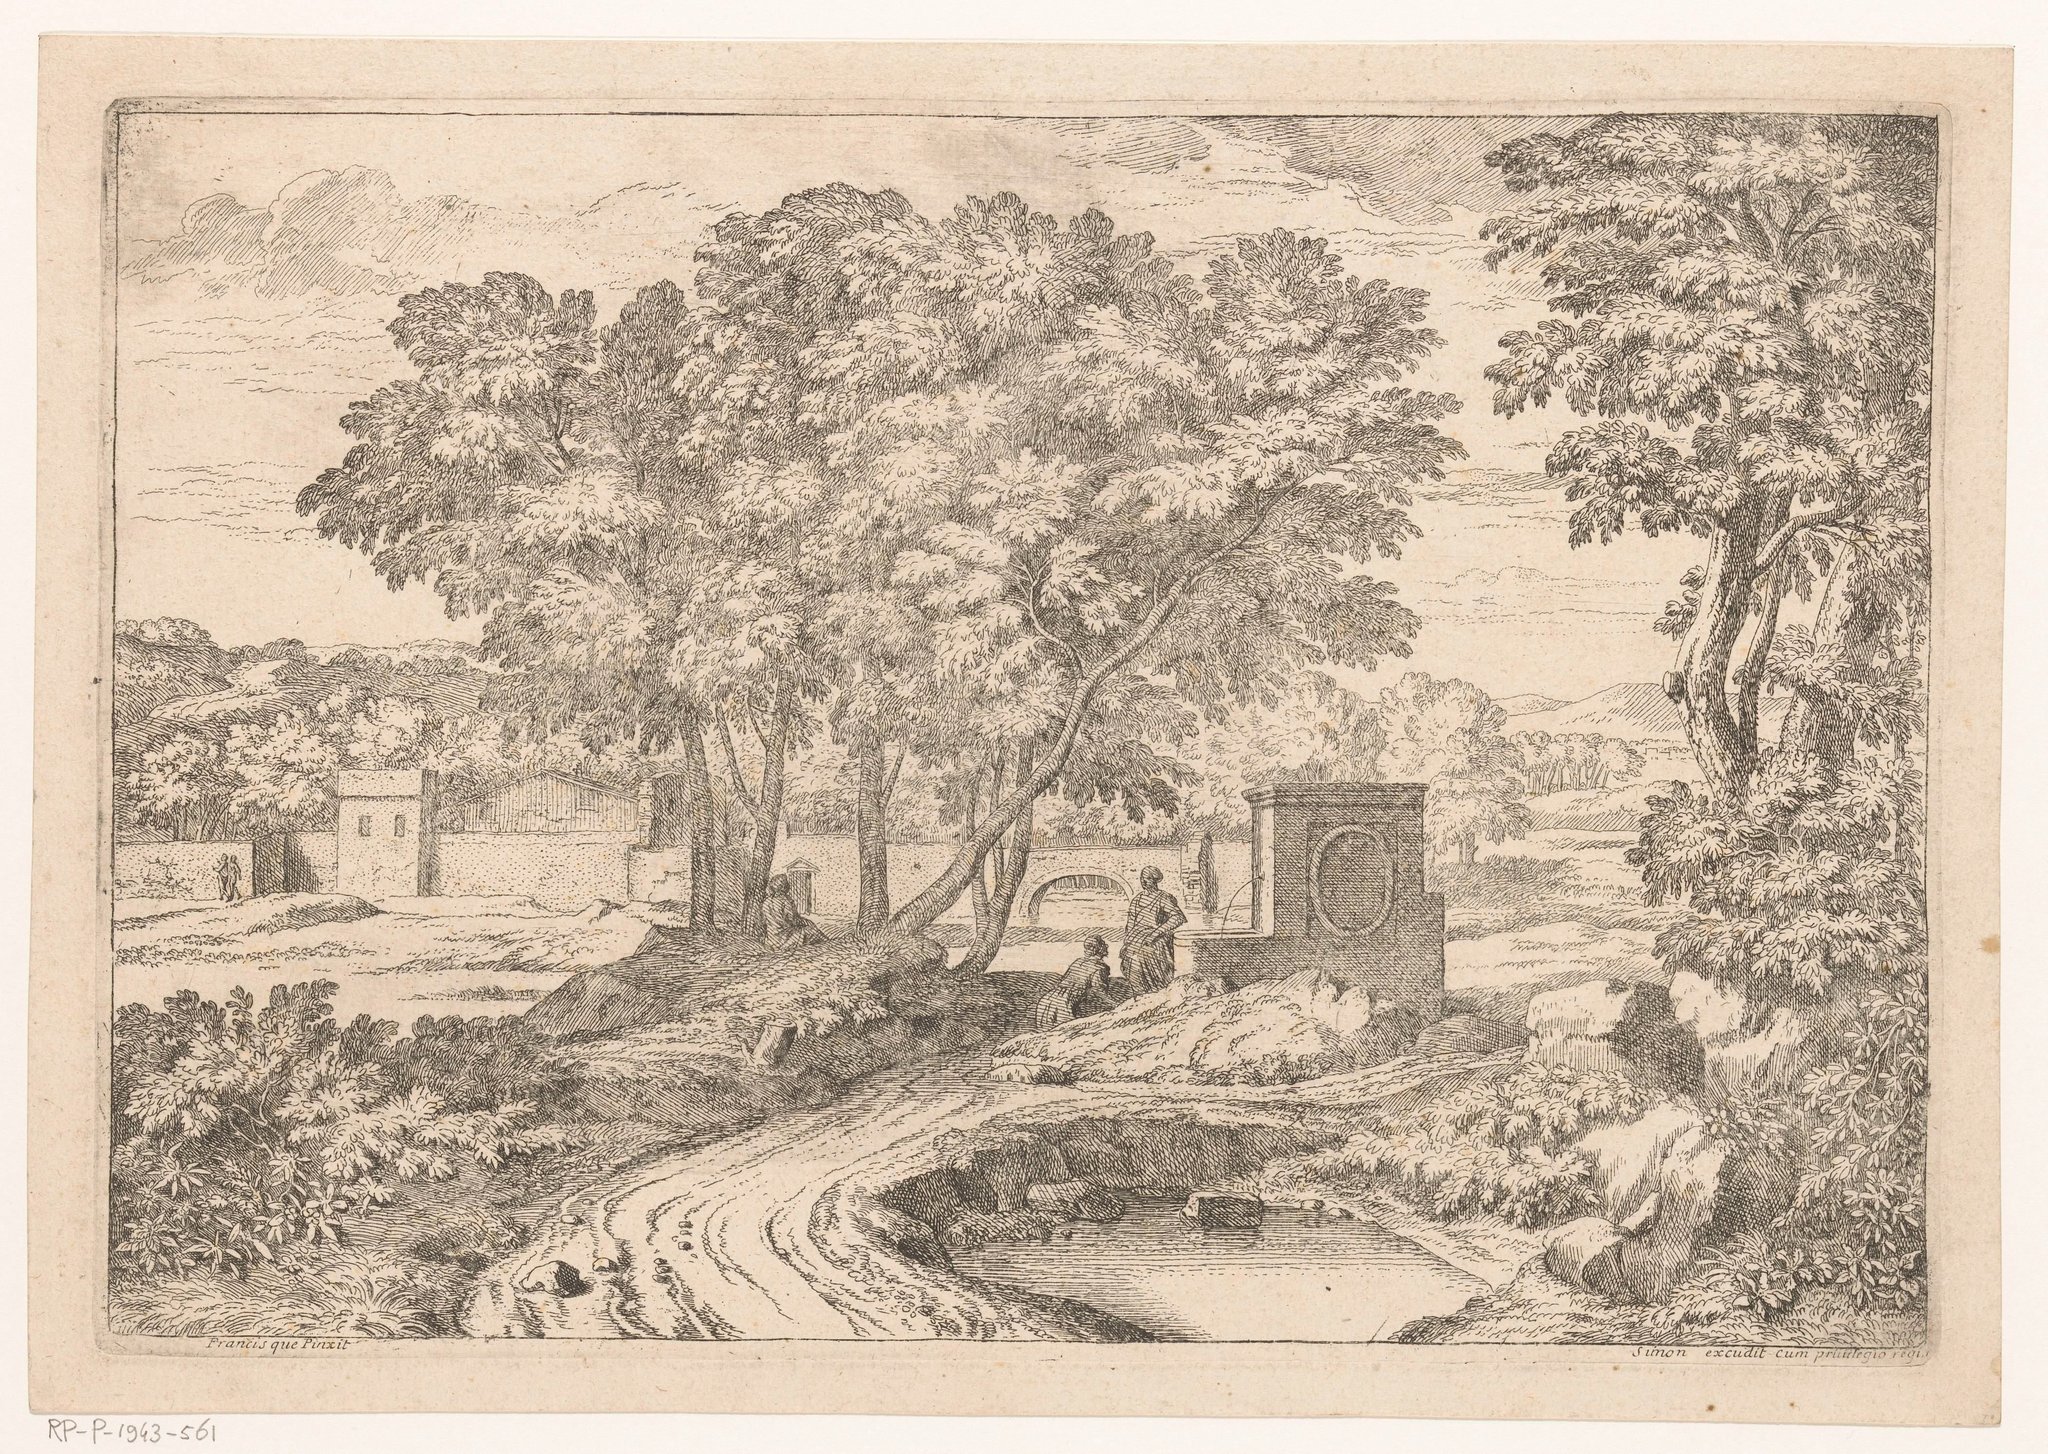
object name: print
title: Arcadisch landschap met twee vrouwen bij een fontein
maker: simon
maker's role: publisher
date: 1690-1730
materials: paper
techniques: etching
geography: france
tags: landscapes in the temperate zone - hh - ideal landscapes, utilitarian, public pump or water fountain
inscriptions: collector's mark: Lugt 2228